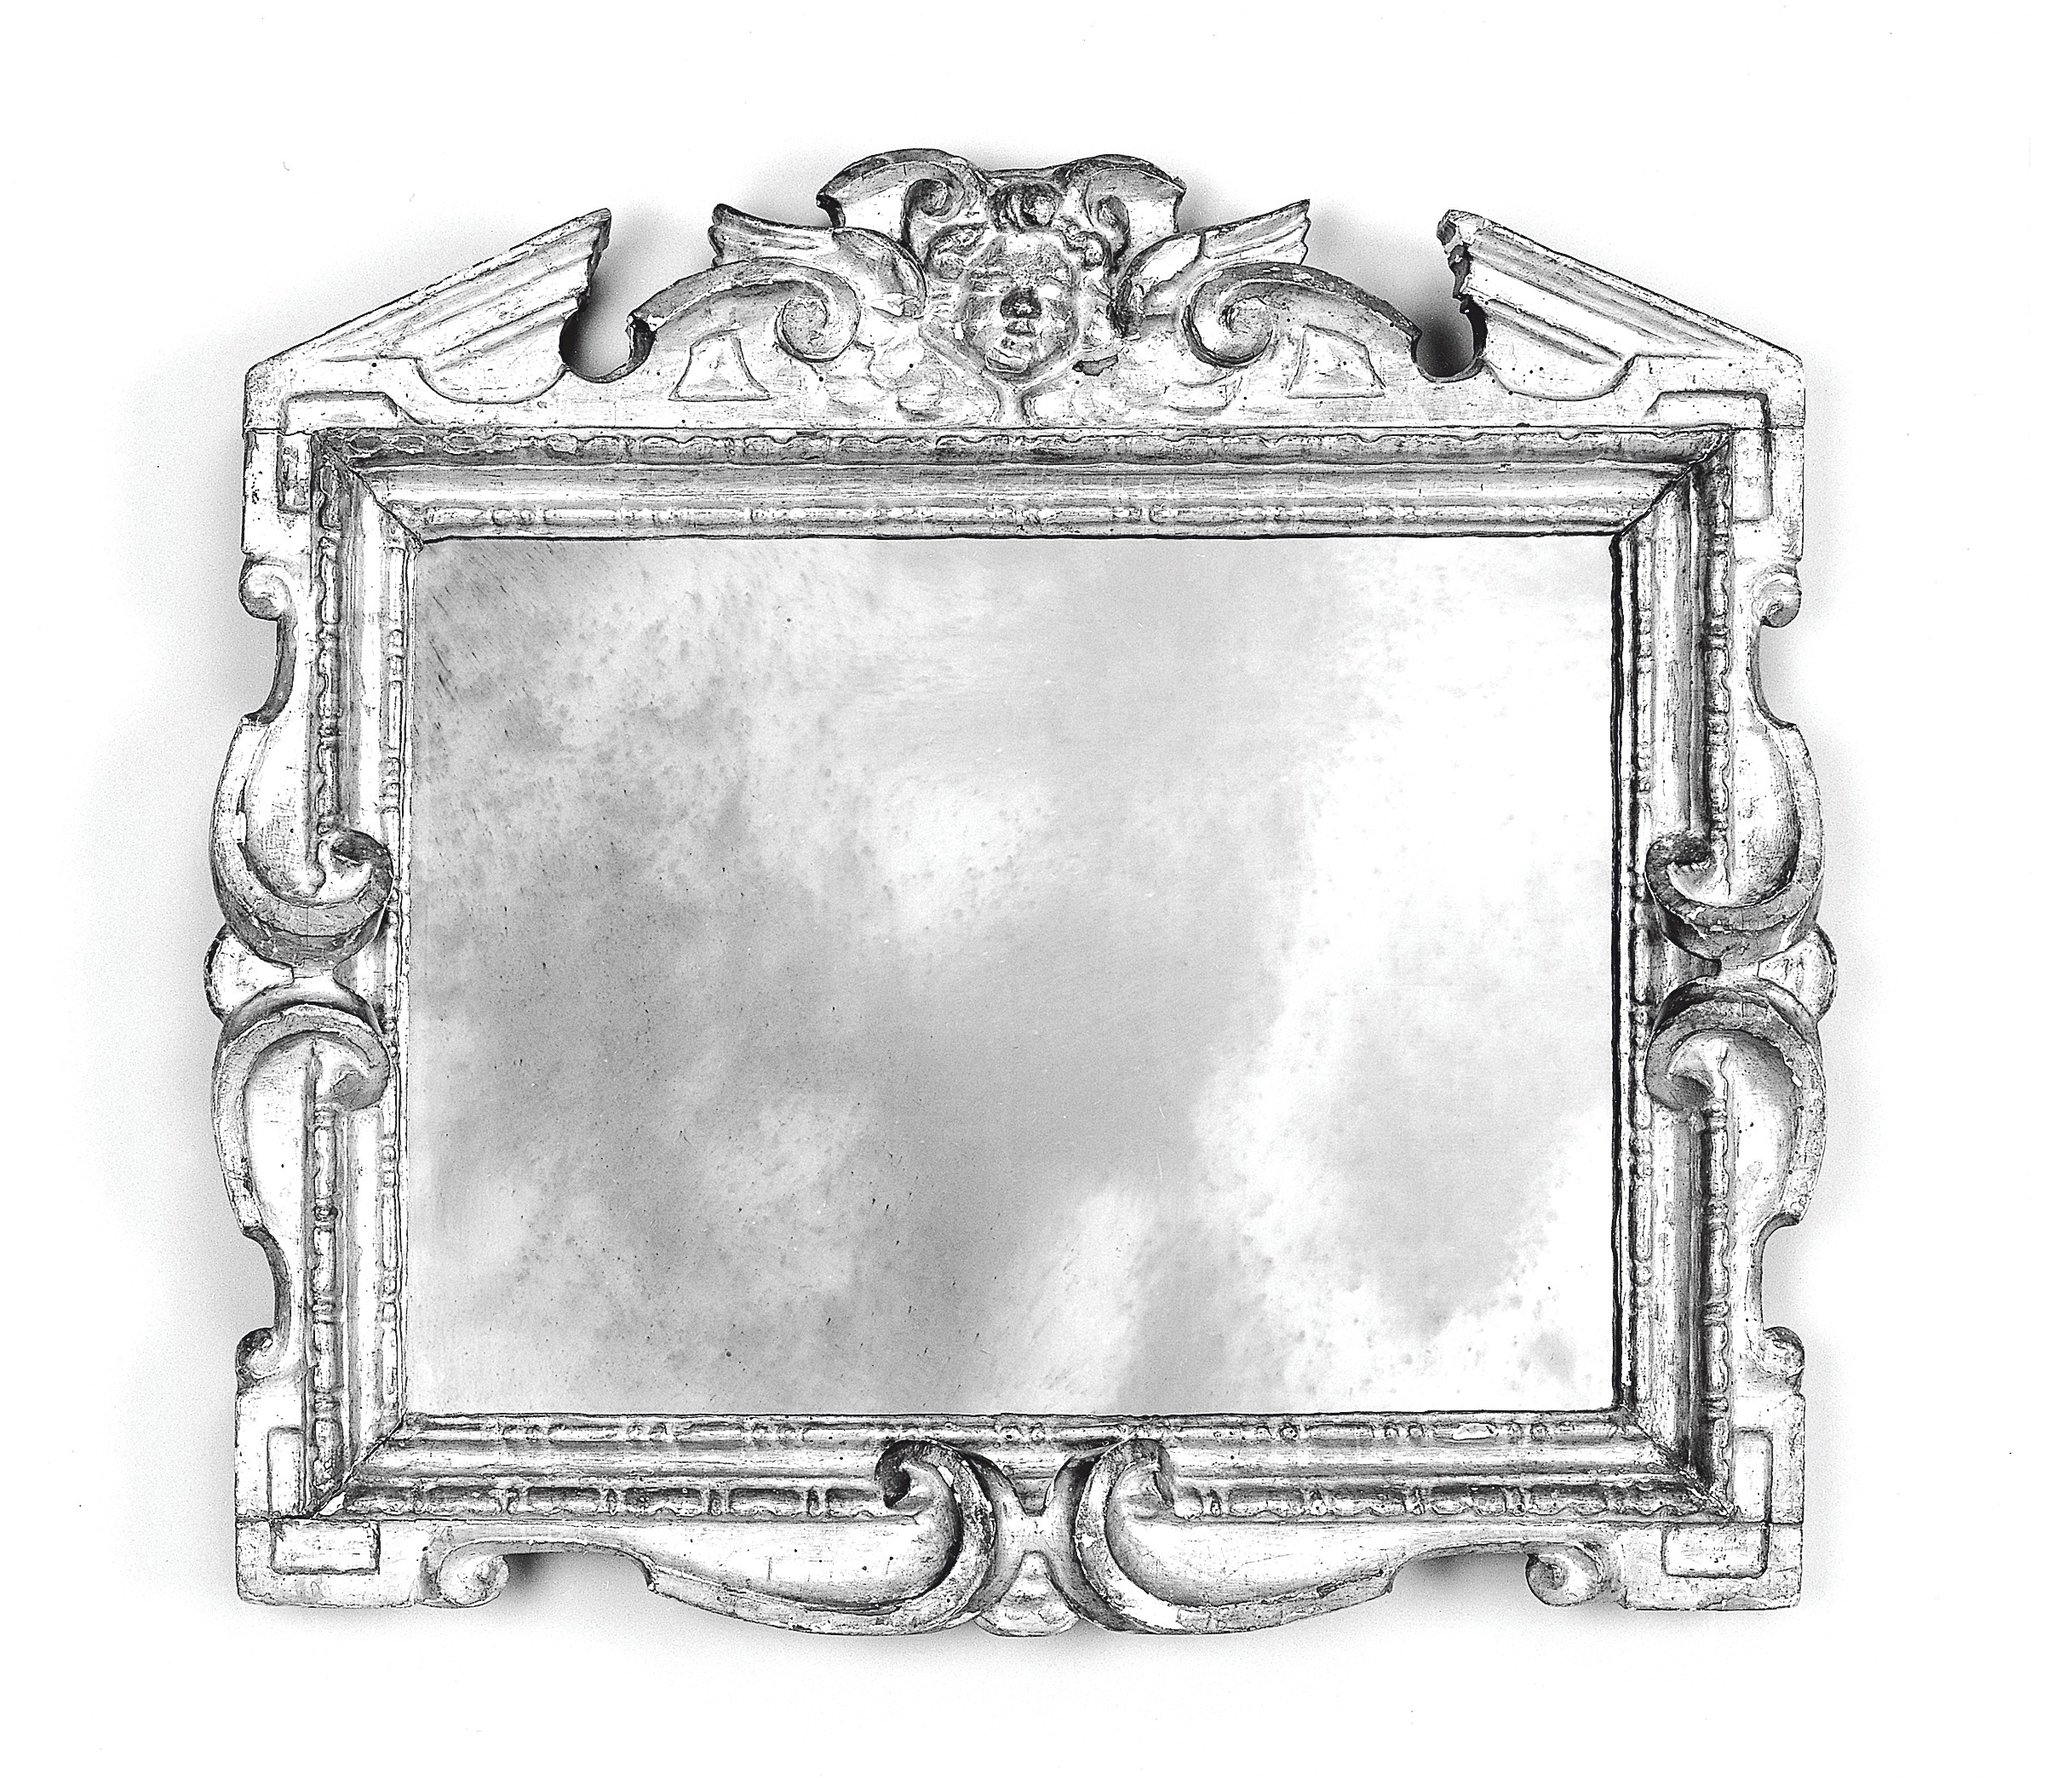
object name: frame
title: Sansovino frame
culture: italian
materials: wood